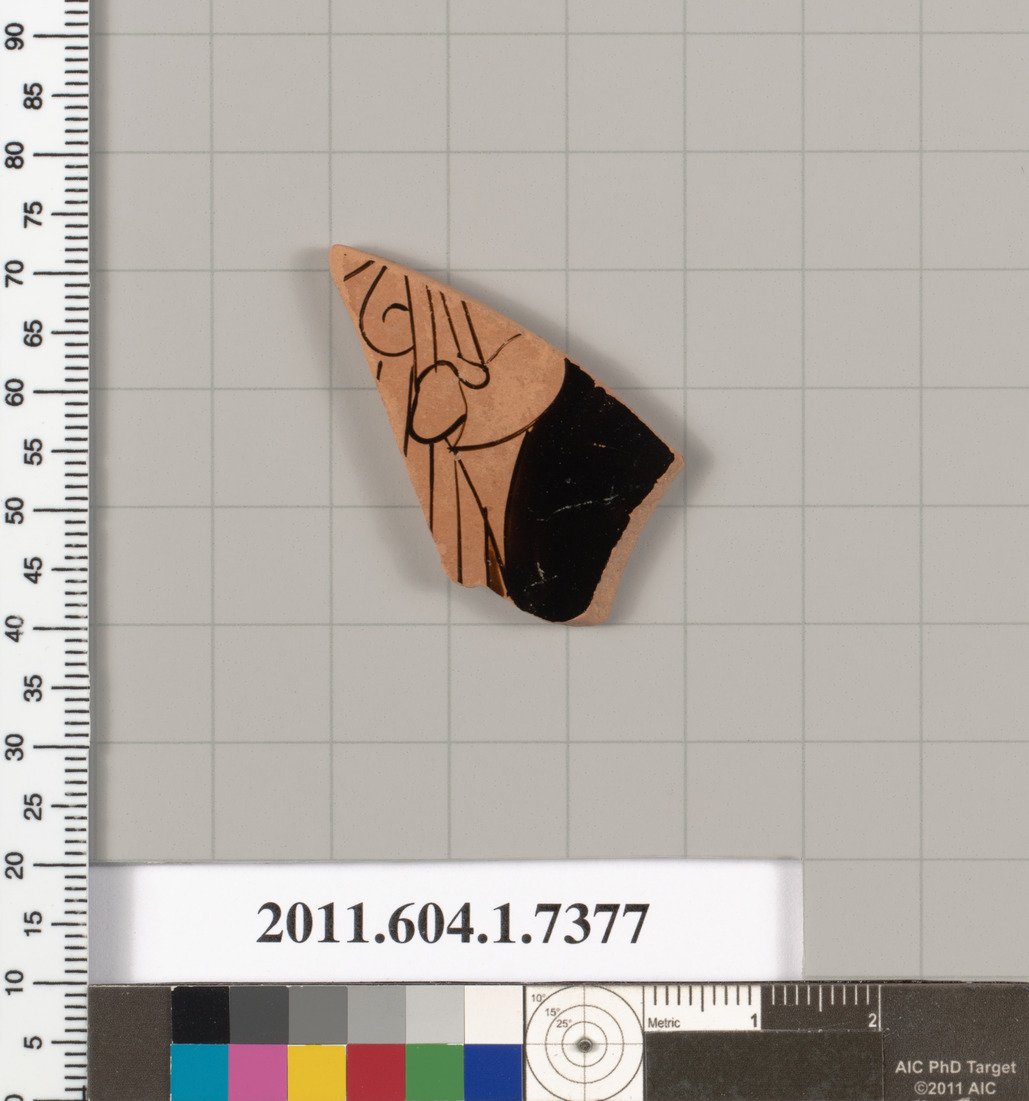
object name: kylix fragment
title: Terracotta fragment of a kylix (drinking cup)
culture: greek, attic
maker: makron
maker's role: artist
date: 500-480 BCE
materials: terracotta